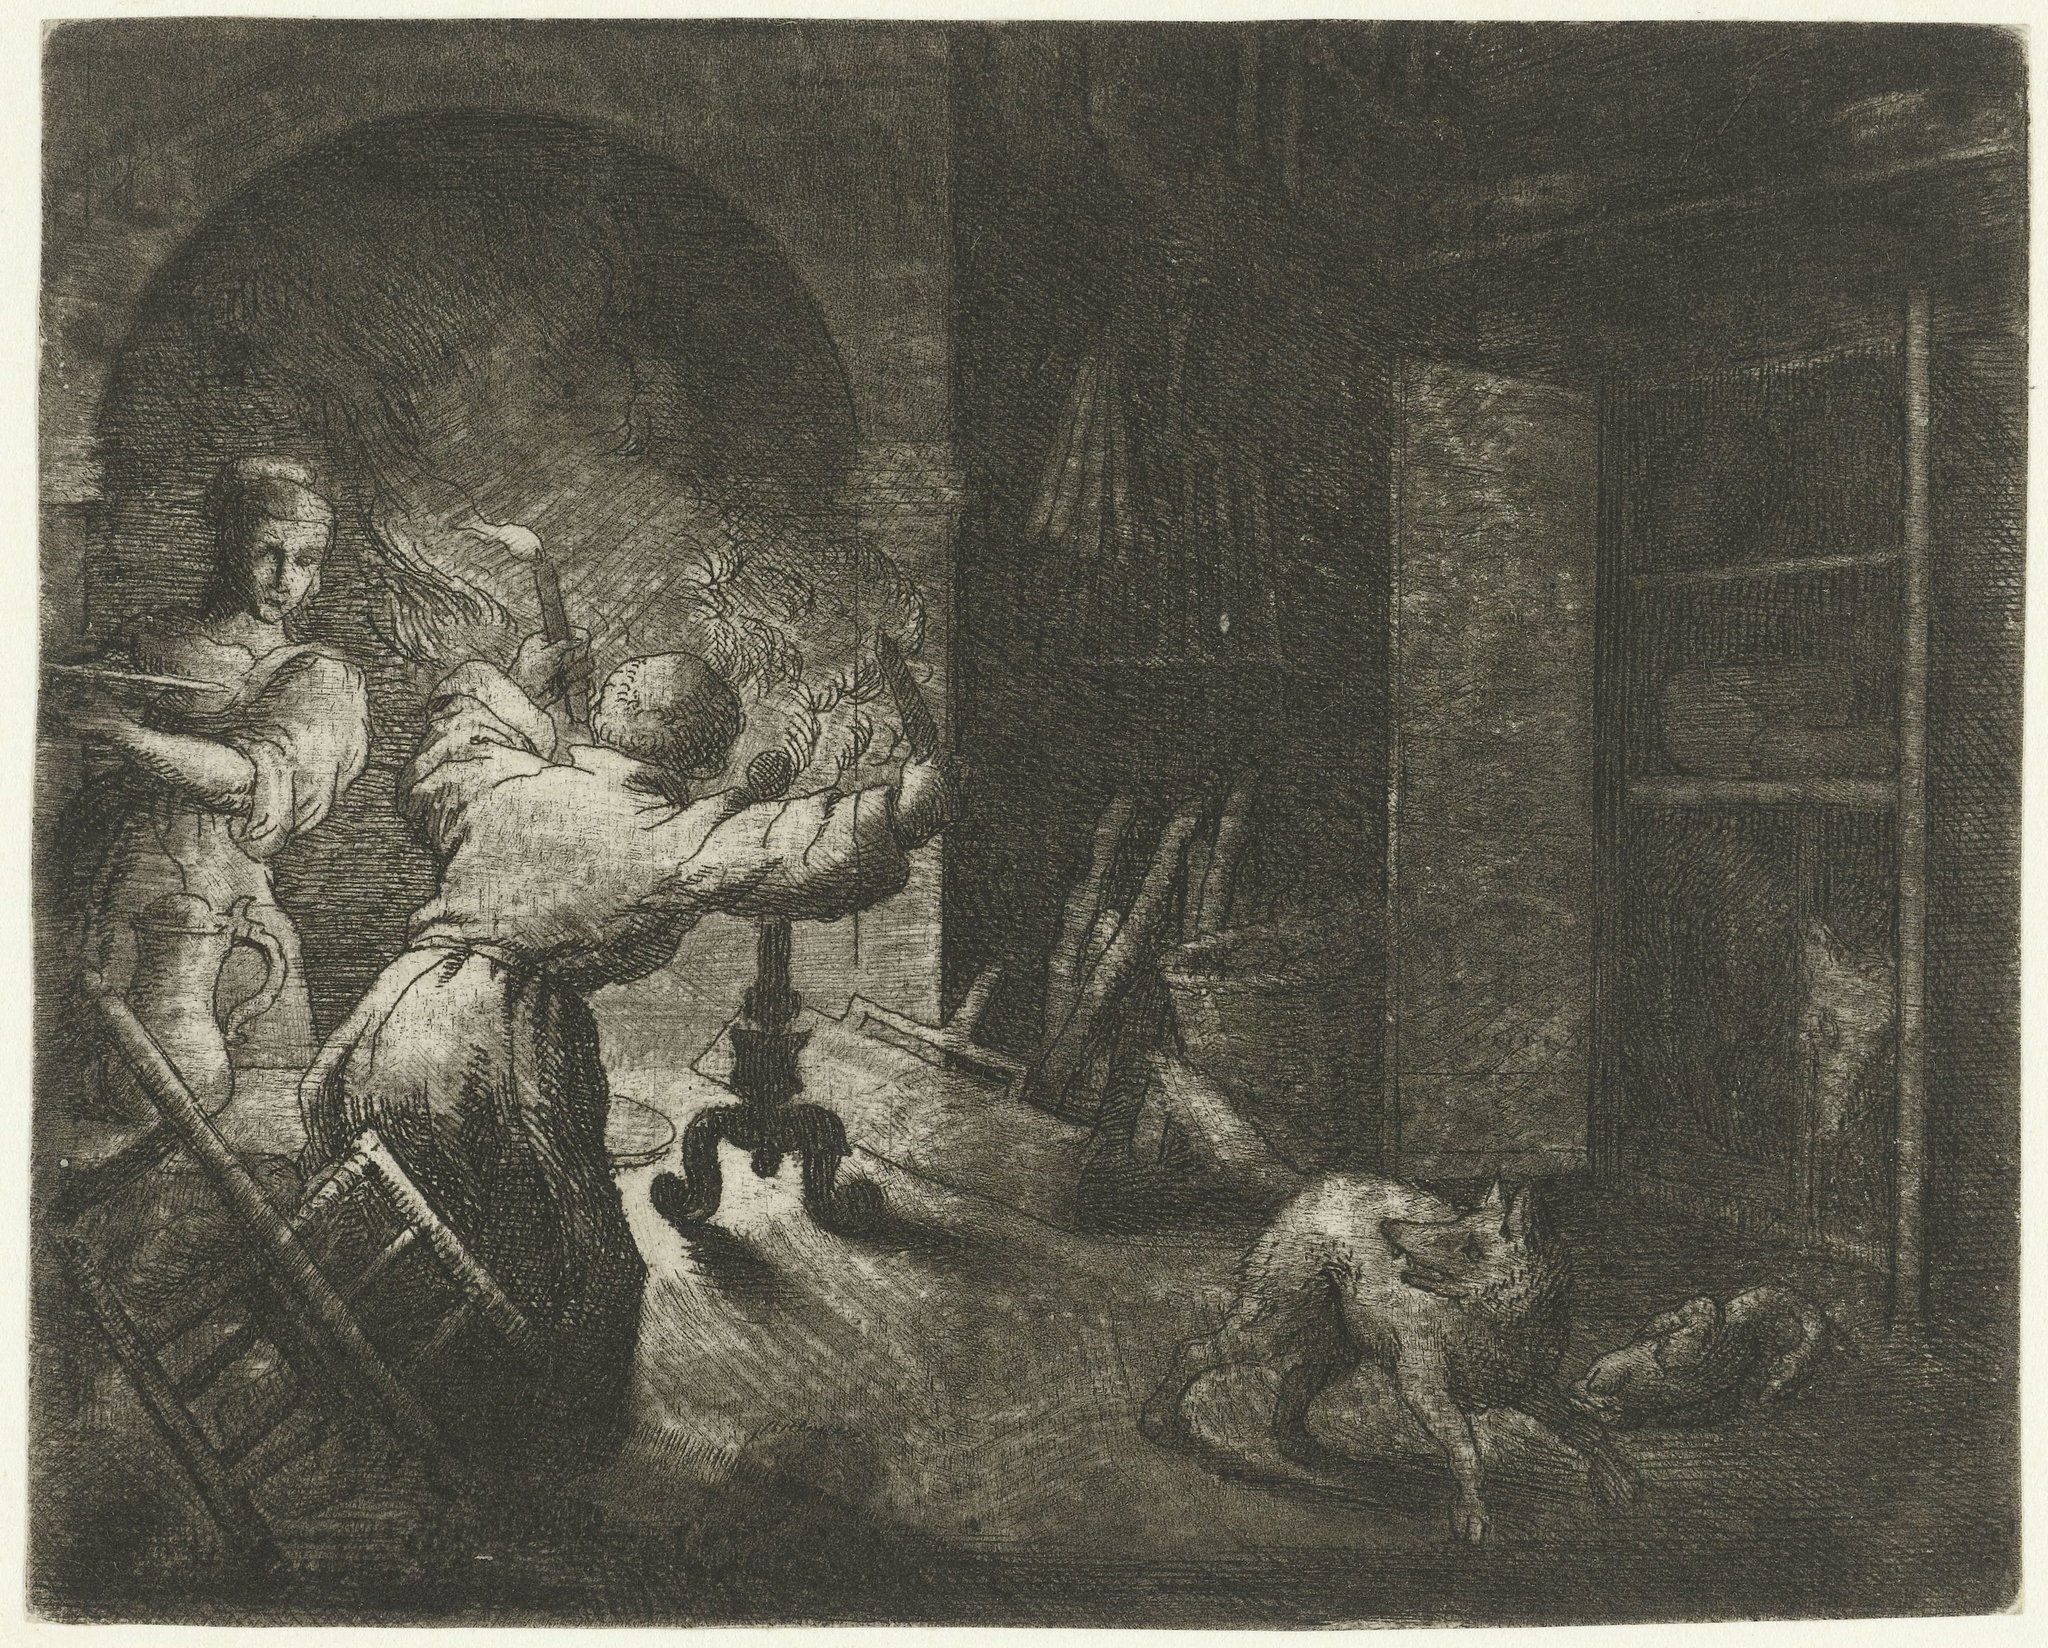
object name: print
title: Reinaert de vos steelt een kapoen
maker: allaert van everdingen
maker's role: draughtsman, painter, print maker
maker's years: 1621-1675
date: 1665-1675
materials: paper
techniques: etching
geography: netherlands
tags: fable of reynard the fox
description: Reinaert de vos, met naast hem de gestolen haan, rent weg voor de pastoor die met een mes en een kaars in handen van tafel opstaat. In de kast zit Isengrijn de wolf verstopt.